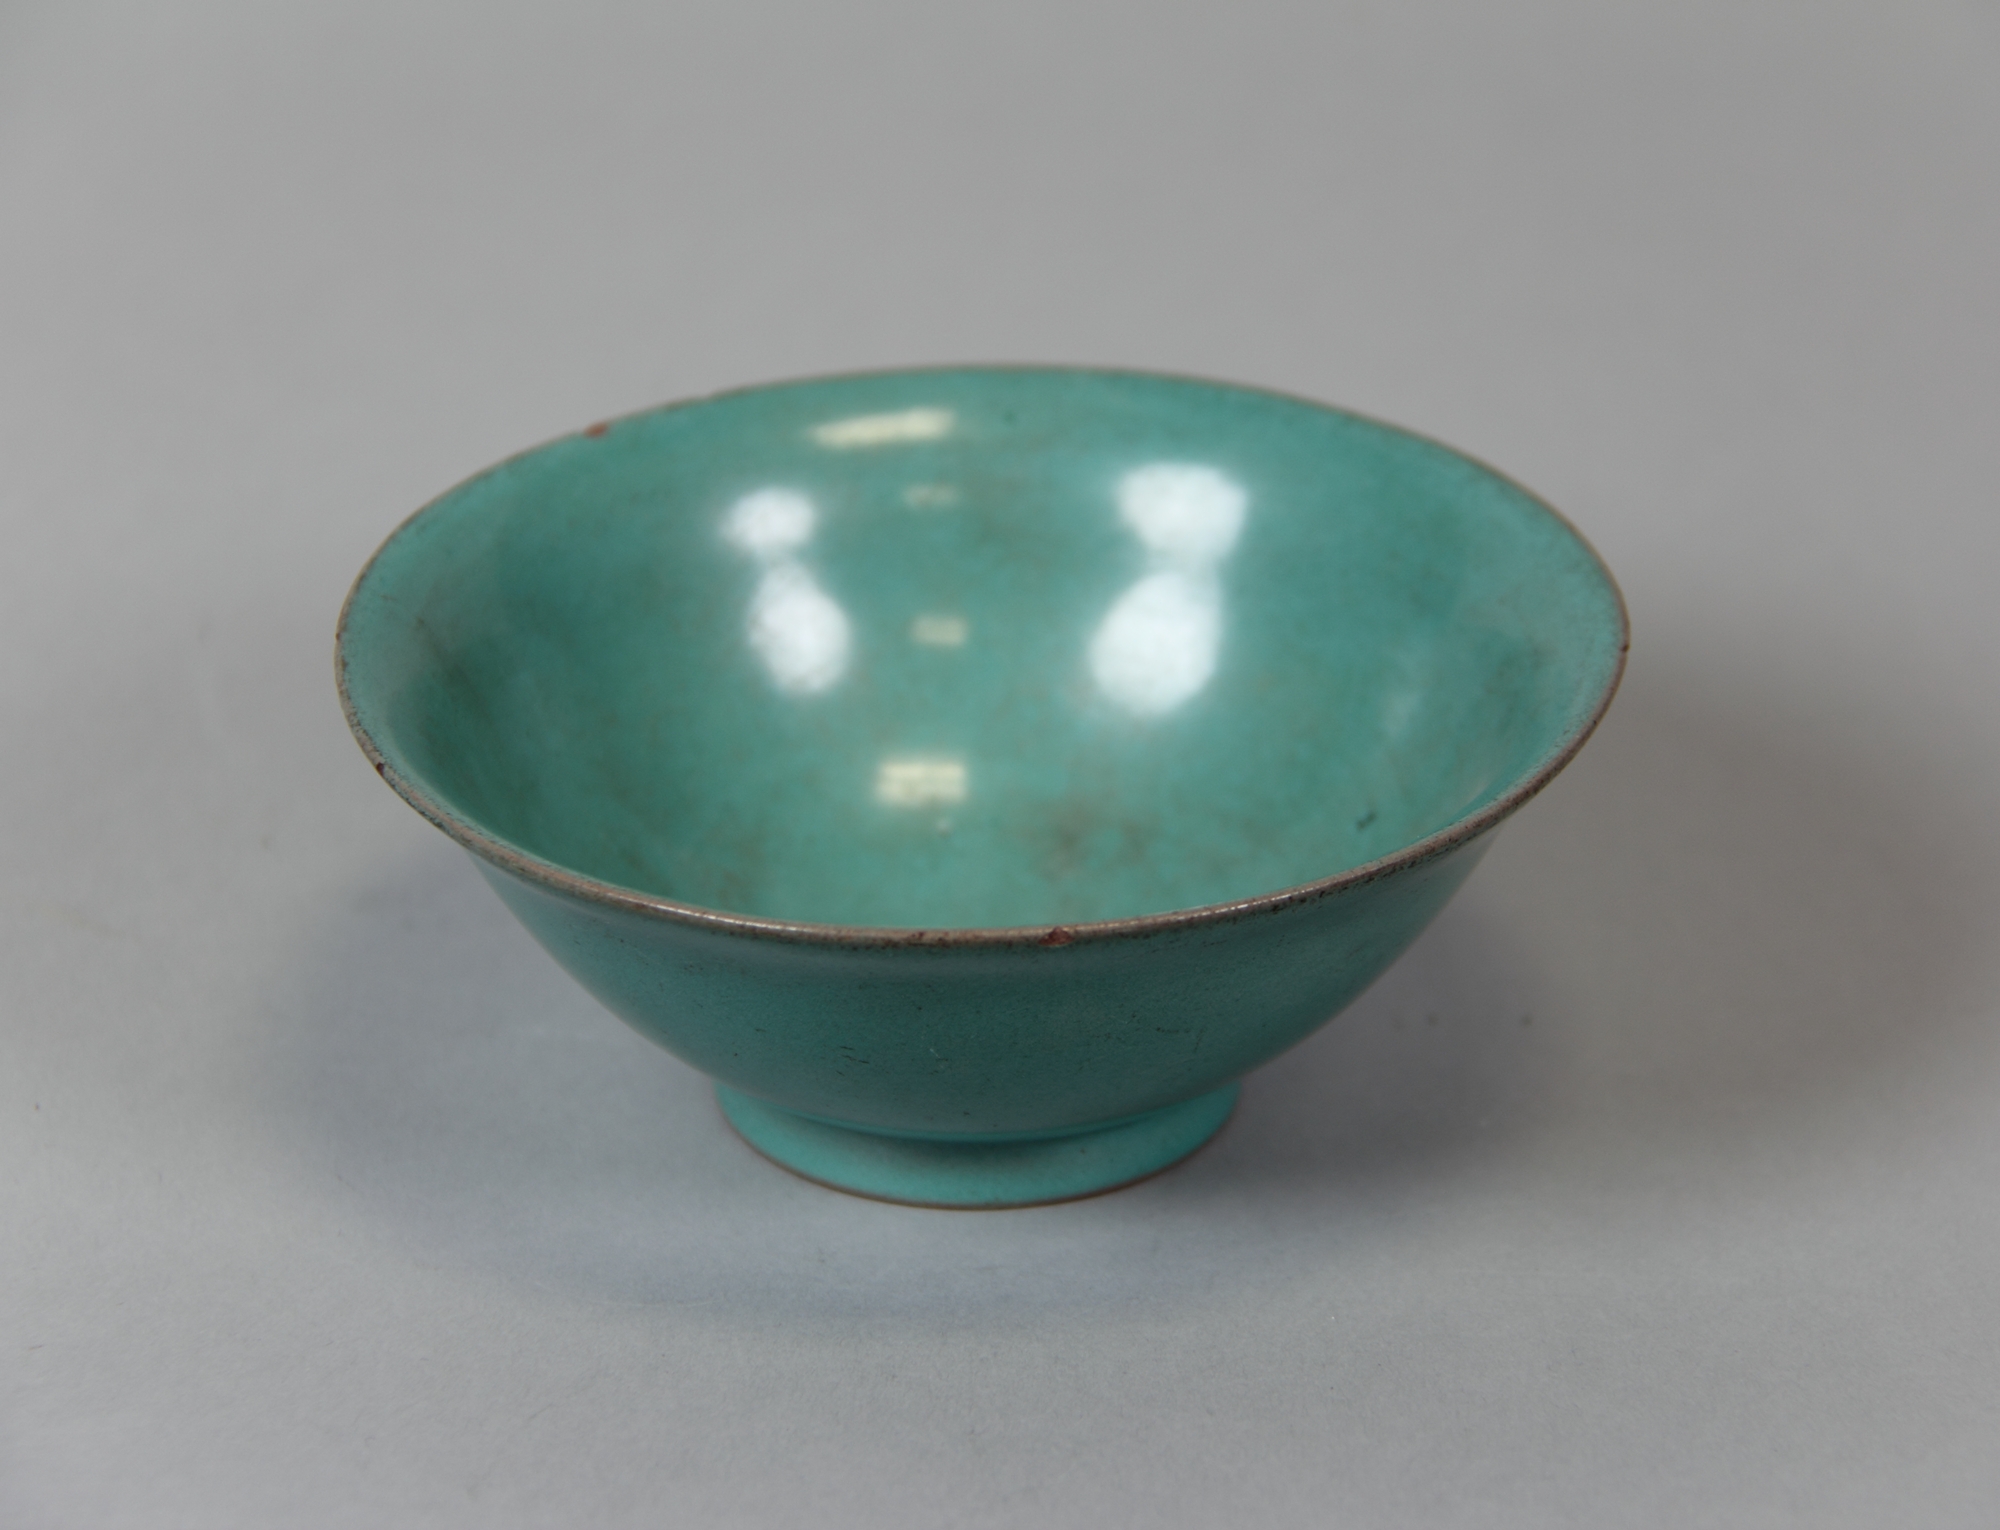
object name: bowl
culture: chinese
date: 1644-1911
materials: glaze, stoneware